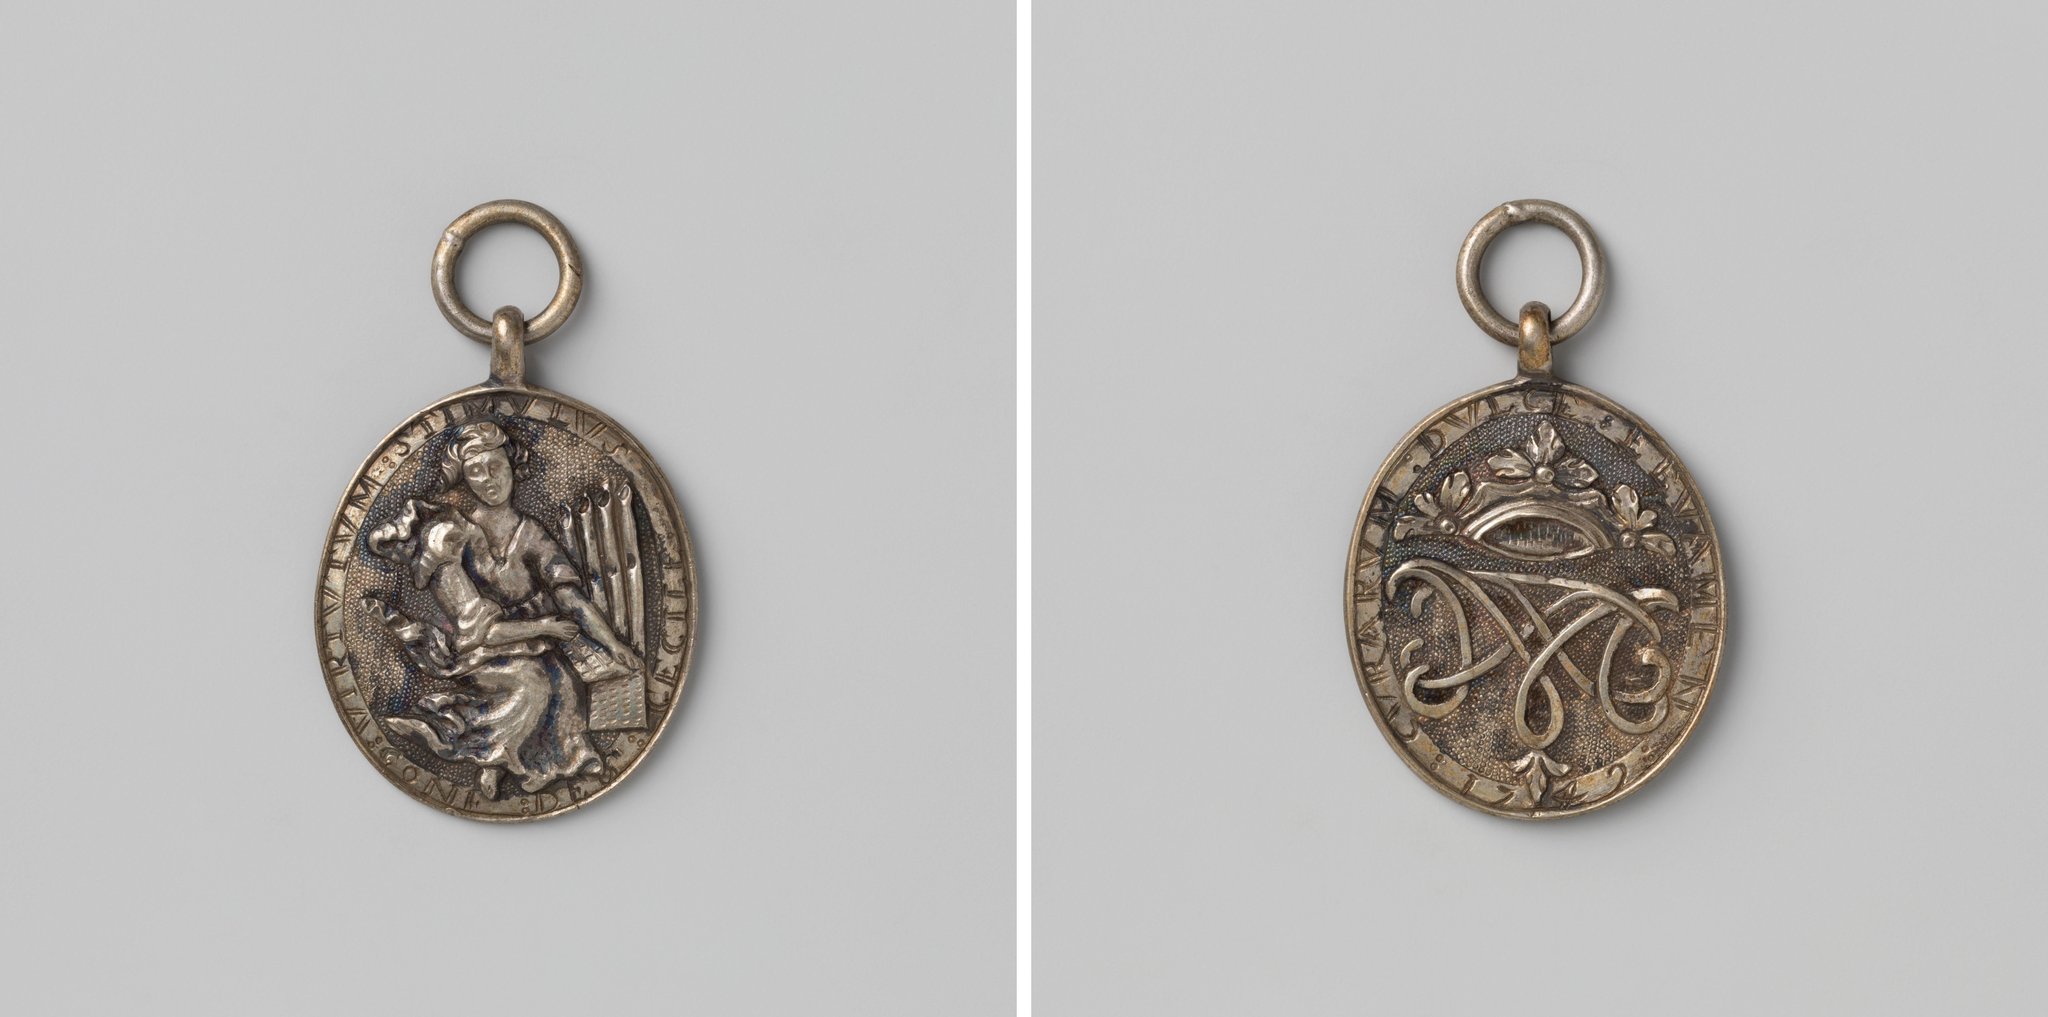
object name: insignia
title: St. Cecilia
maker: Anonymous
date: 1742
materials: silver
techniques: casting, engraving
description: eenzijdig draagteken aan draagoog en draagring. Voorzijde: St. Cecilia zittend naast aantal orgelpijpen binnen omschrift. Keerzijde: gekroond siermotief binnen omschrift